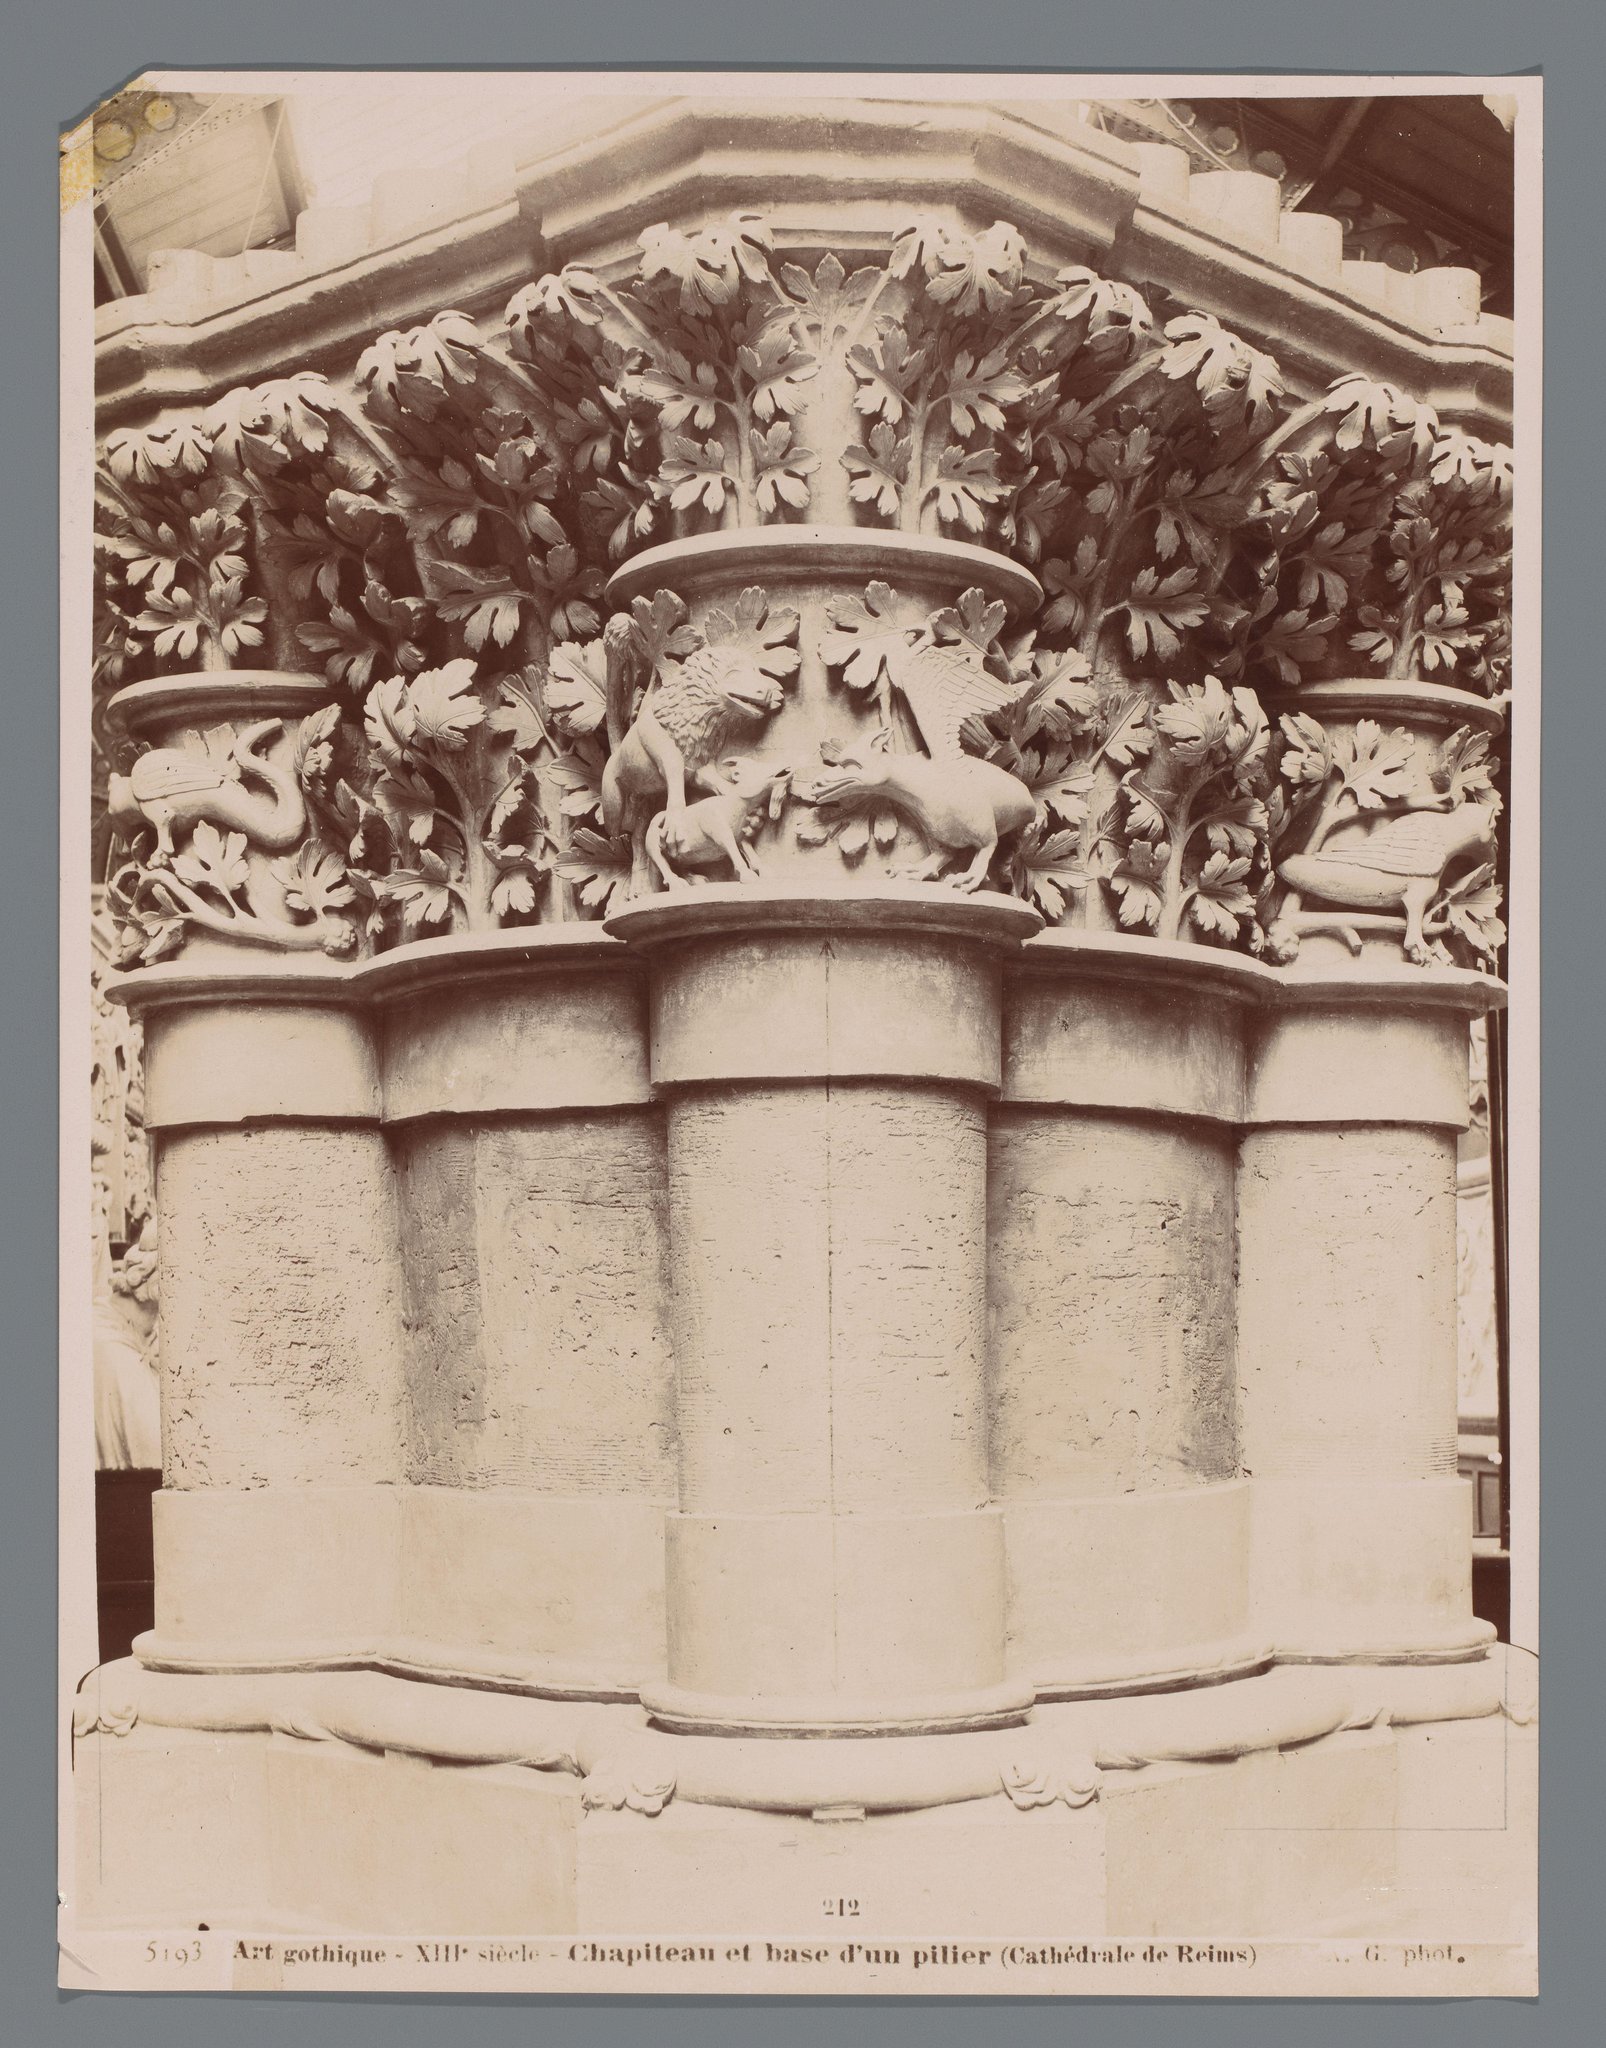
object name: photograph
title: Reims Cathedral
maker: Anonymous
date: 1870-1900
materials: photographic support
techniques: gelatin silver print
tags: kathedraal van reims